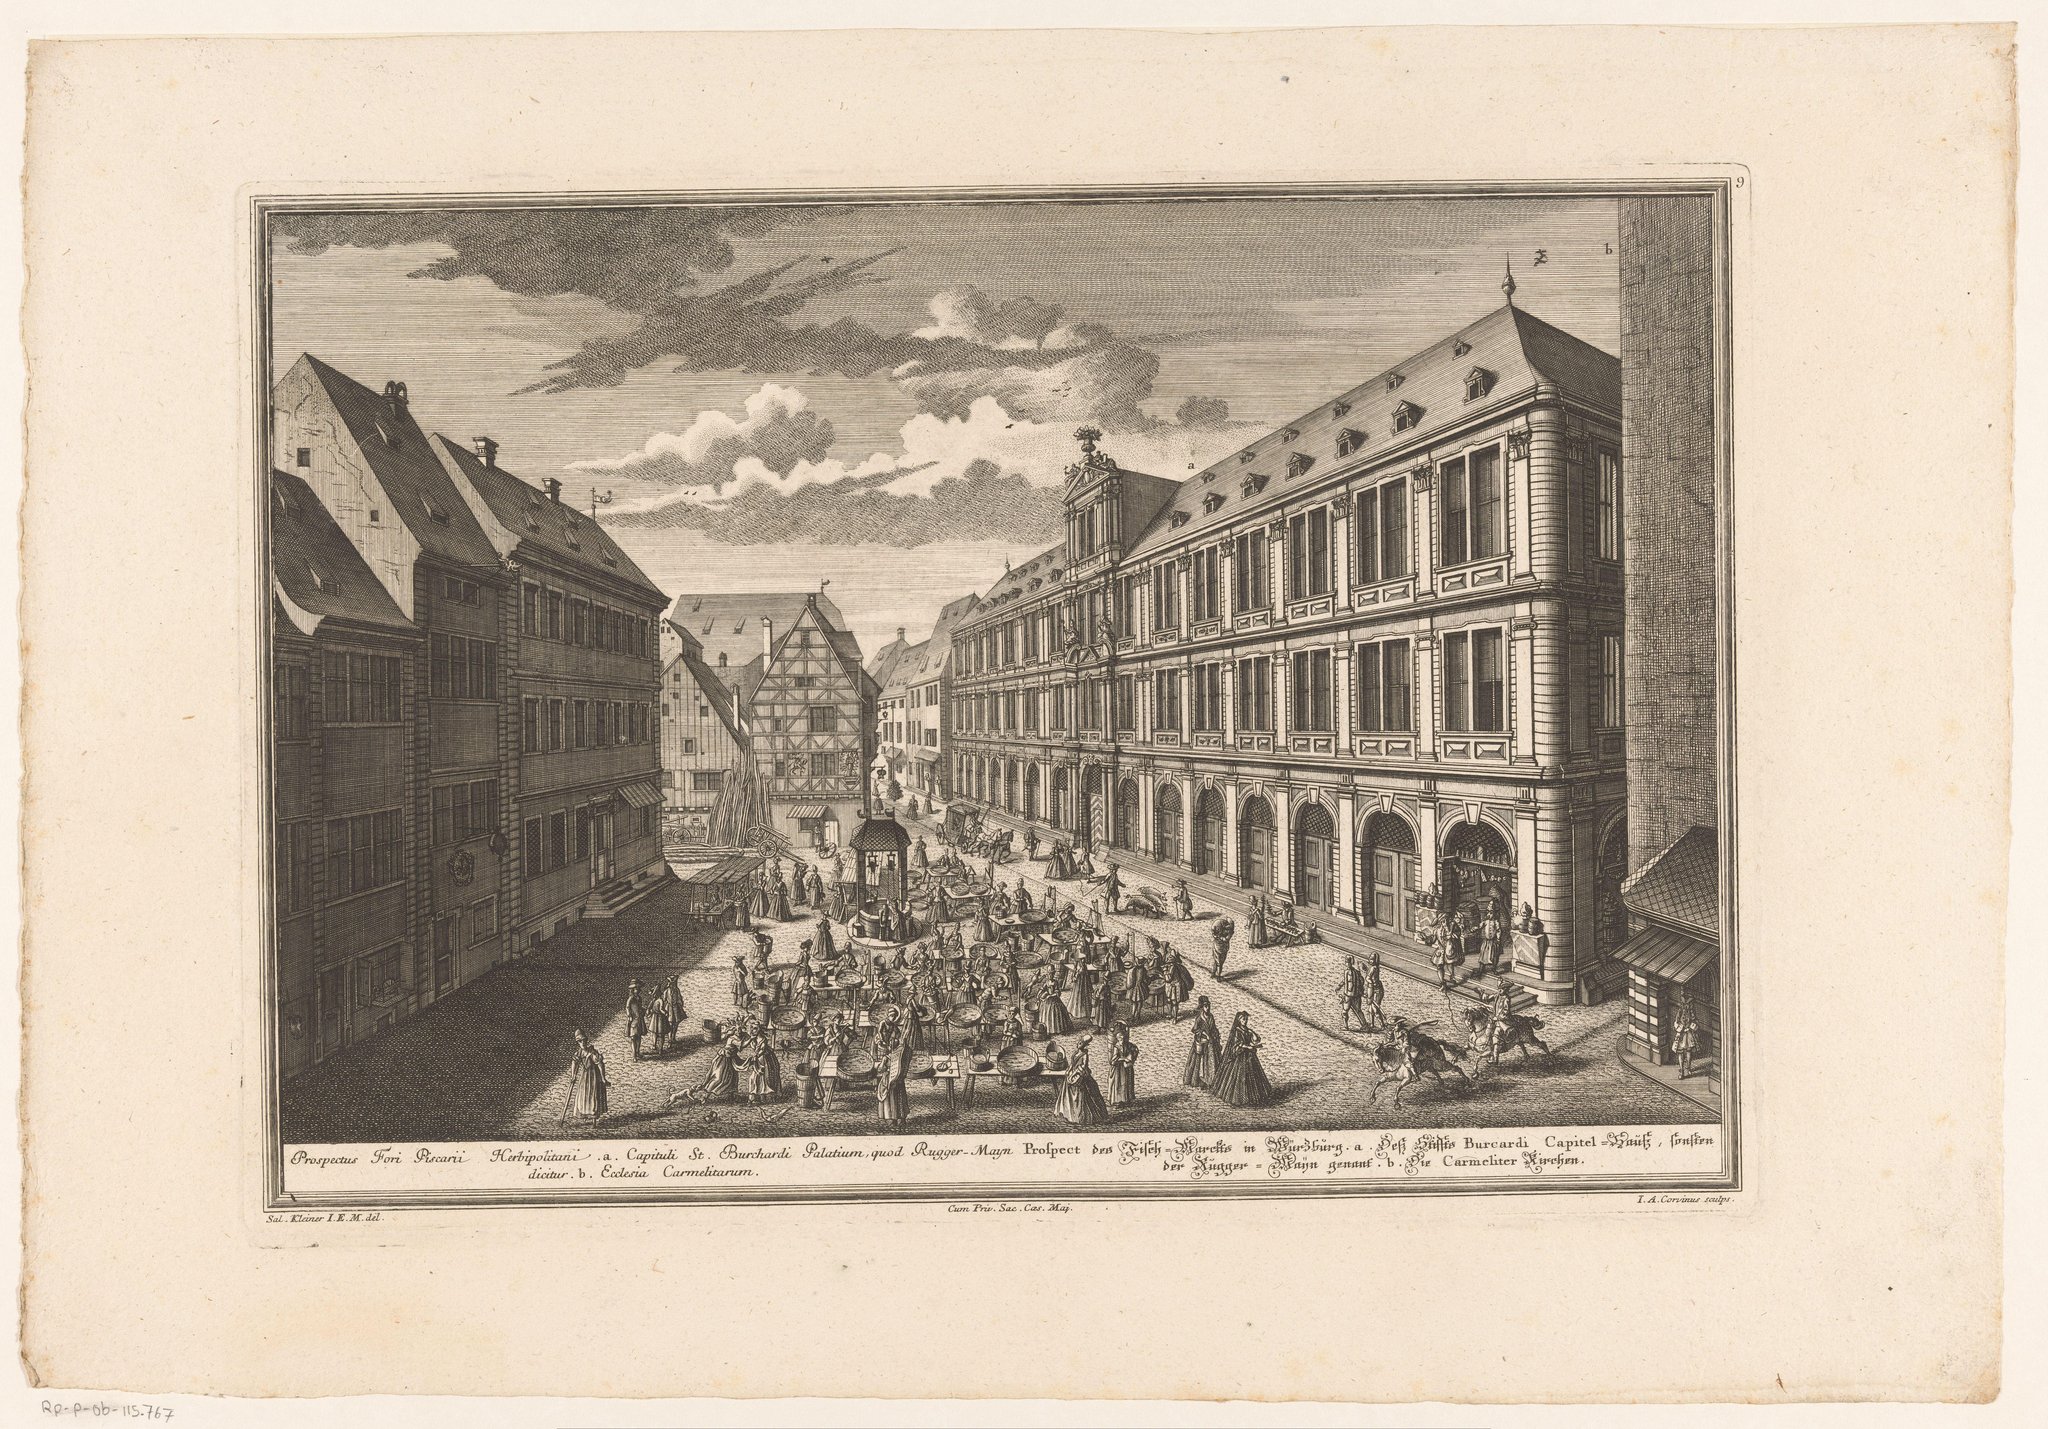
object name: print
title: Elf stadsgezichten van Würzburg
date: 1740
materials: paper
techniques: engraving, etching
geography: augsburg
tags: city-view, and landscape with man-made constructions, market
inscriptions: collector's mark: Lugt 2228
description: Serie bestaande uit elf prenten plus een titelprent. Johann Andreas Pfeffel wordt op de titelprent aangeduid als prentmaker, maar zijn naam staat op de prenten niet vermeld.